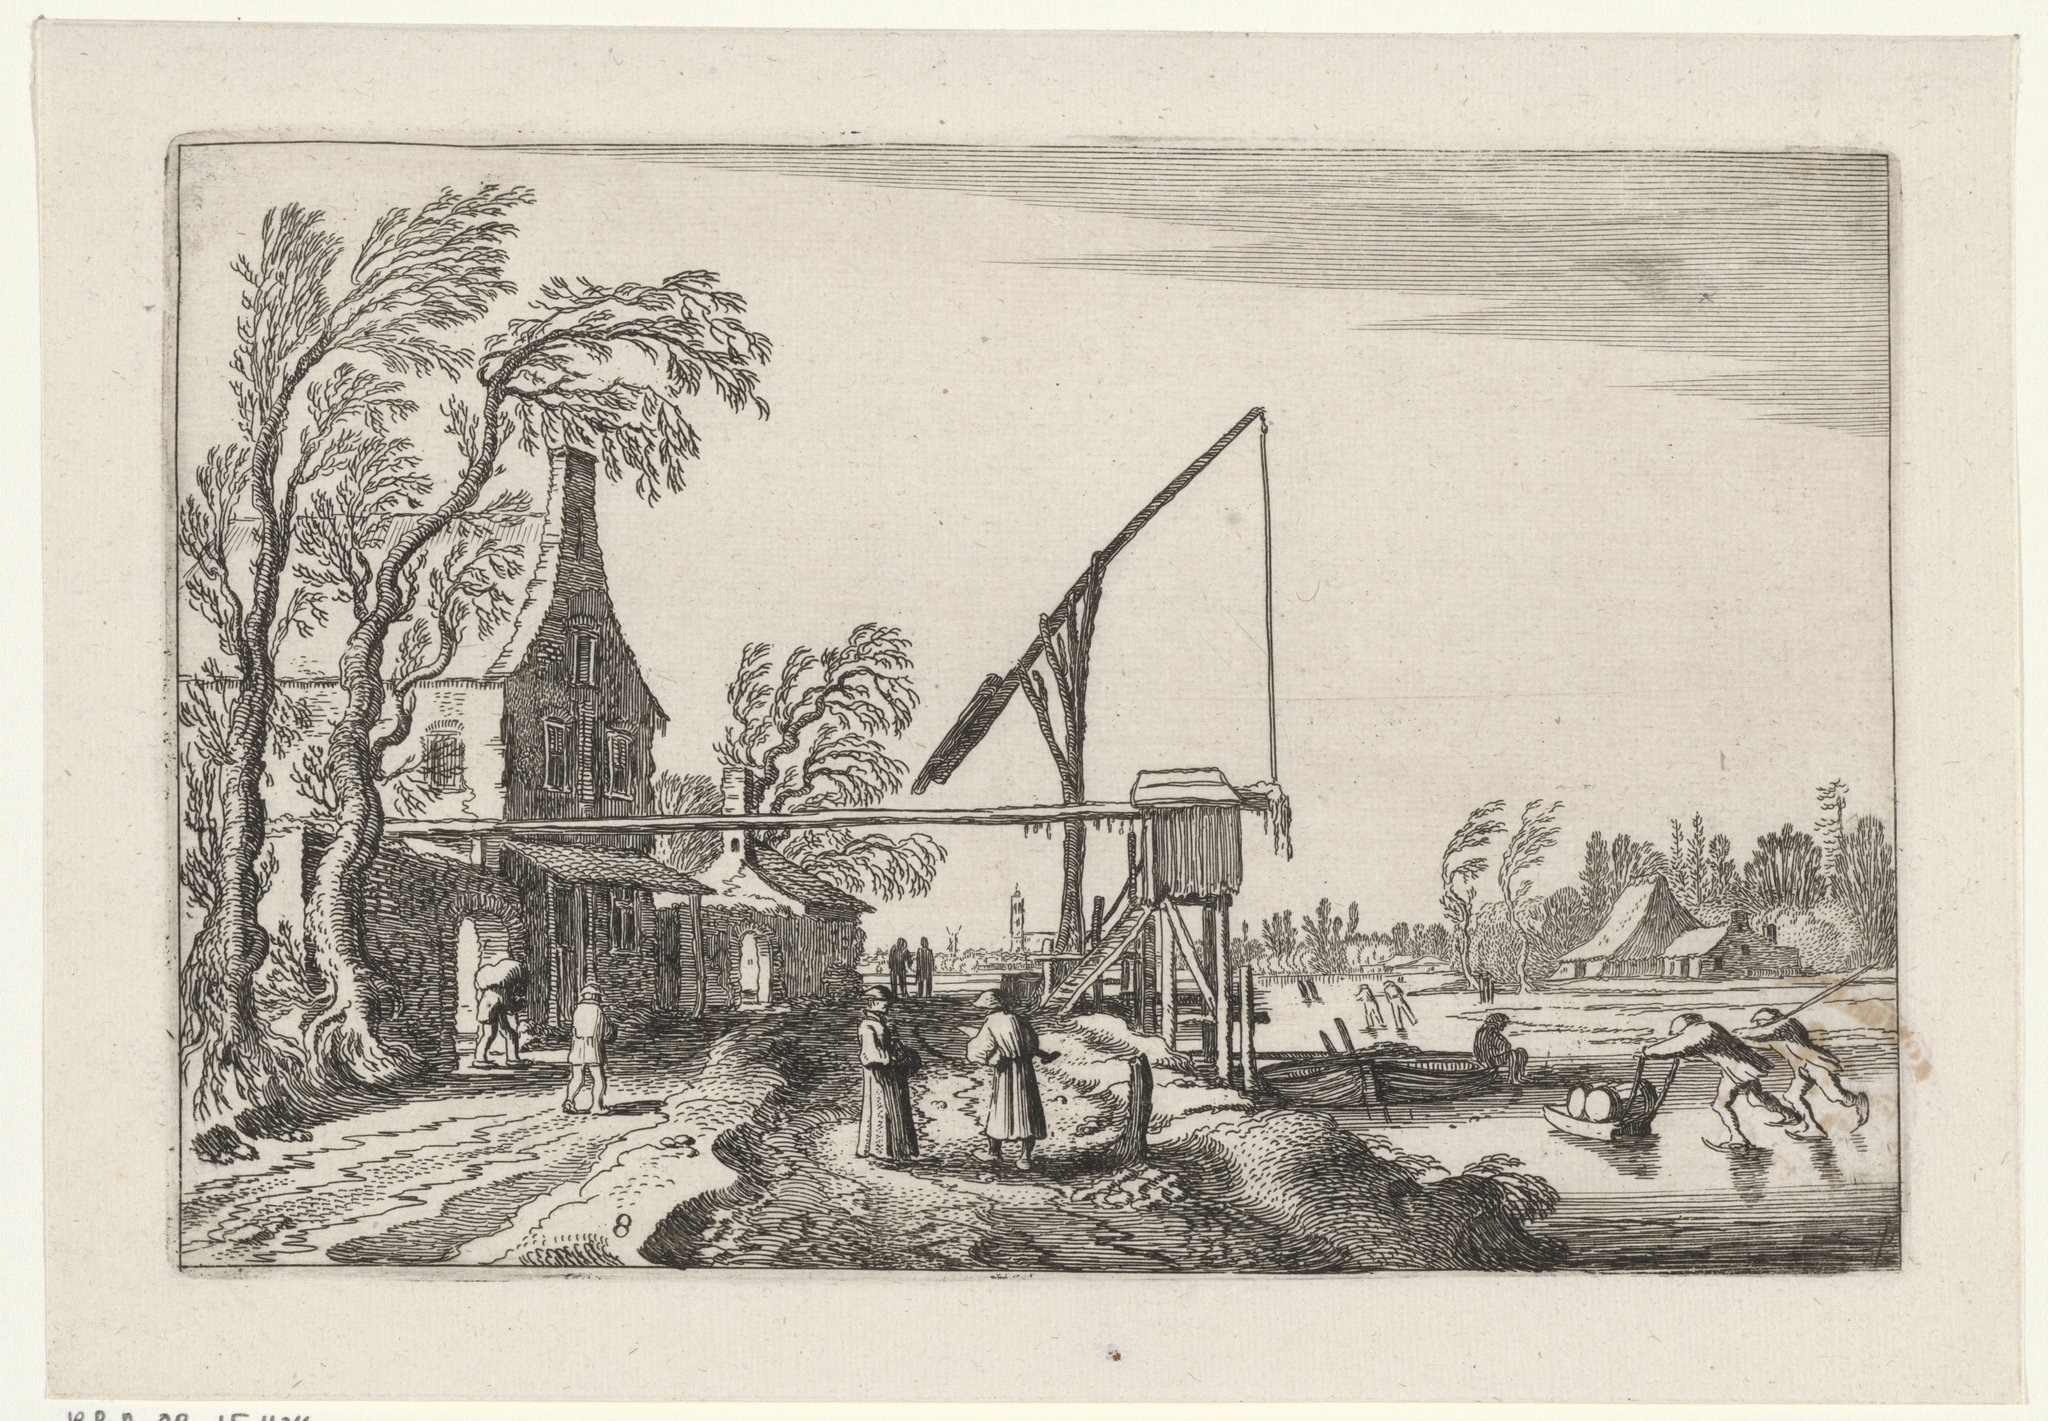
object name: print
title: Schaatsers op het ijs en boeren op een weg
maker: jan van de velde (ii)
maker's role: draughtsman, painter, print maker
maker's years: 1593-1641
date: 1616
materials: paper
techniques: etching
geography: northern netherlands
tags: skates (winter sports), public road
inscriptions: collector's mark: Lugt 240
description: Schaatsers op het ijs en boeren op een weg bij huizen. Achtste prent van een serie van zestien.